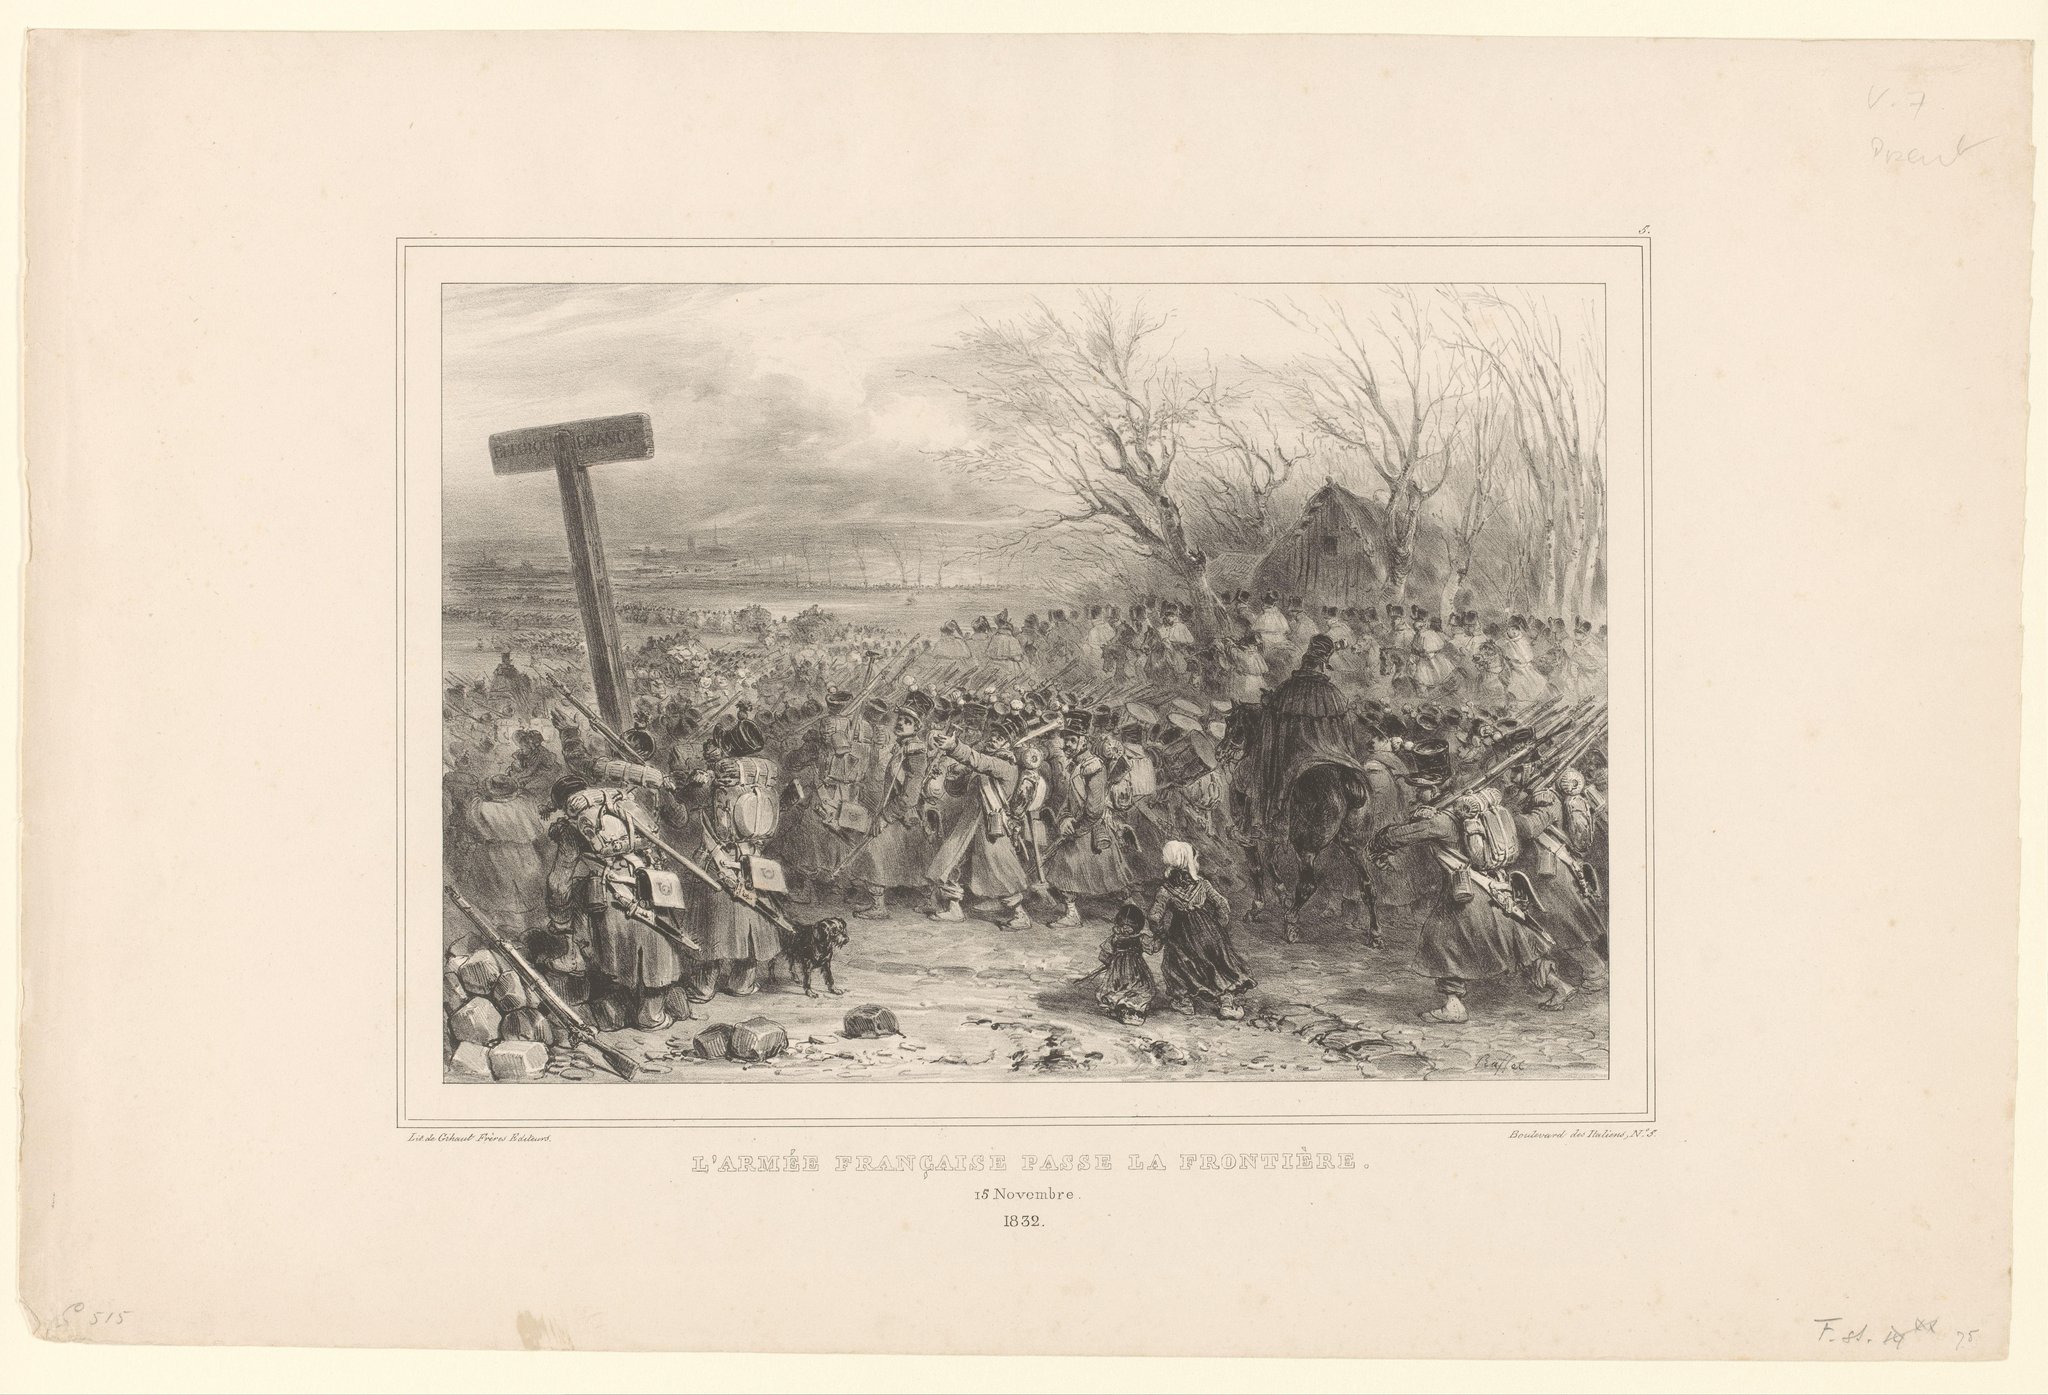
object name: print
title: Beleg van de citadel van Antwerpen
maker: denis auguste marie raffet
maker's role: draughtsman, print maker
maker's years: 1804-1860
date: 1833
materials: paper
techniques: lithograph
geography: paris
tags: siege, position war, the soldier; the soldier's life, transport, train (military), division of armed forces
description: Grote onderdelen van het oprukkende Franse leger te voet en te paard bij een huis in een landschap. Op de voorgrond twee boerenkinderen hand in hand. Onderdeel van de serie van 24 prenten over het beleg van de Citadel van Antwerpen, 30 november - 23 december 1832.